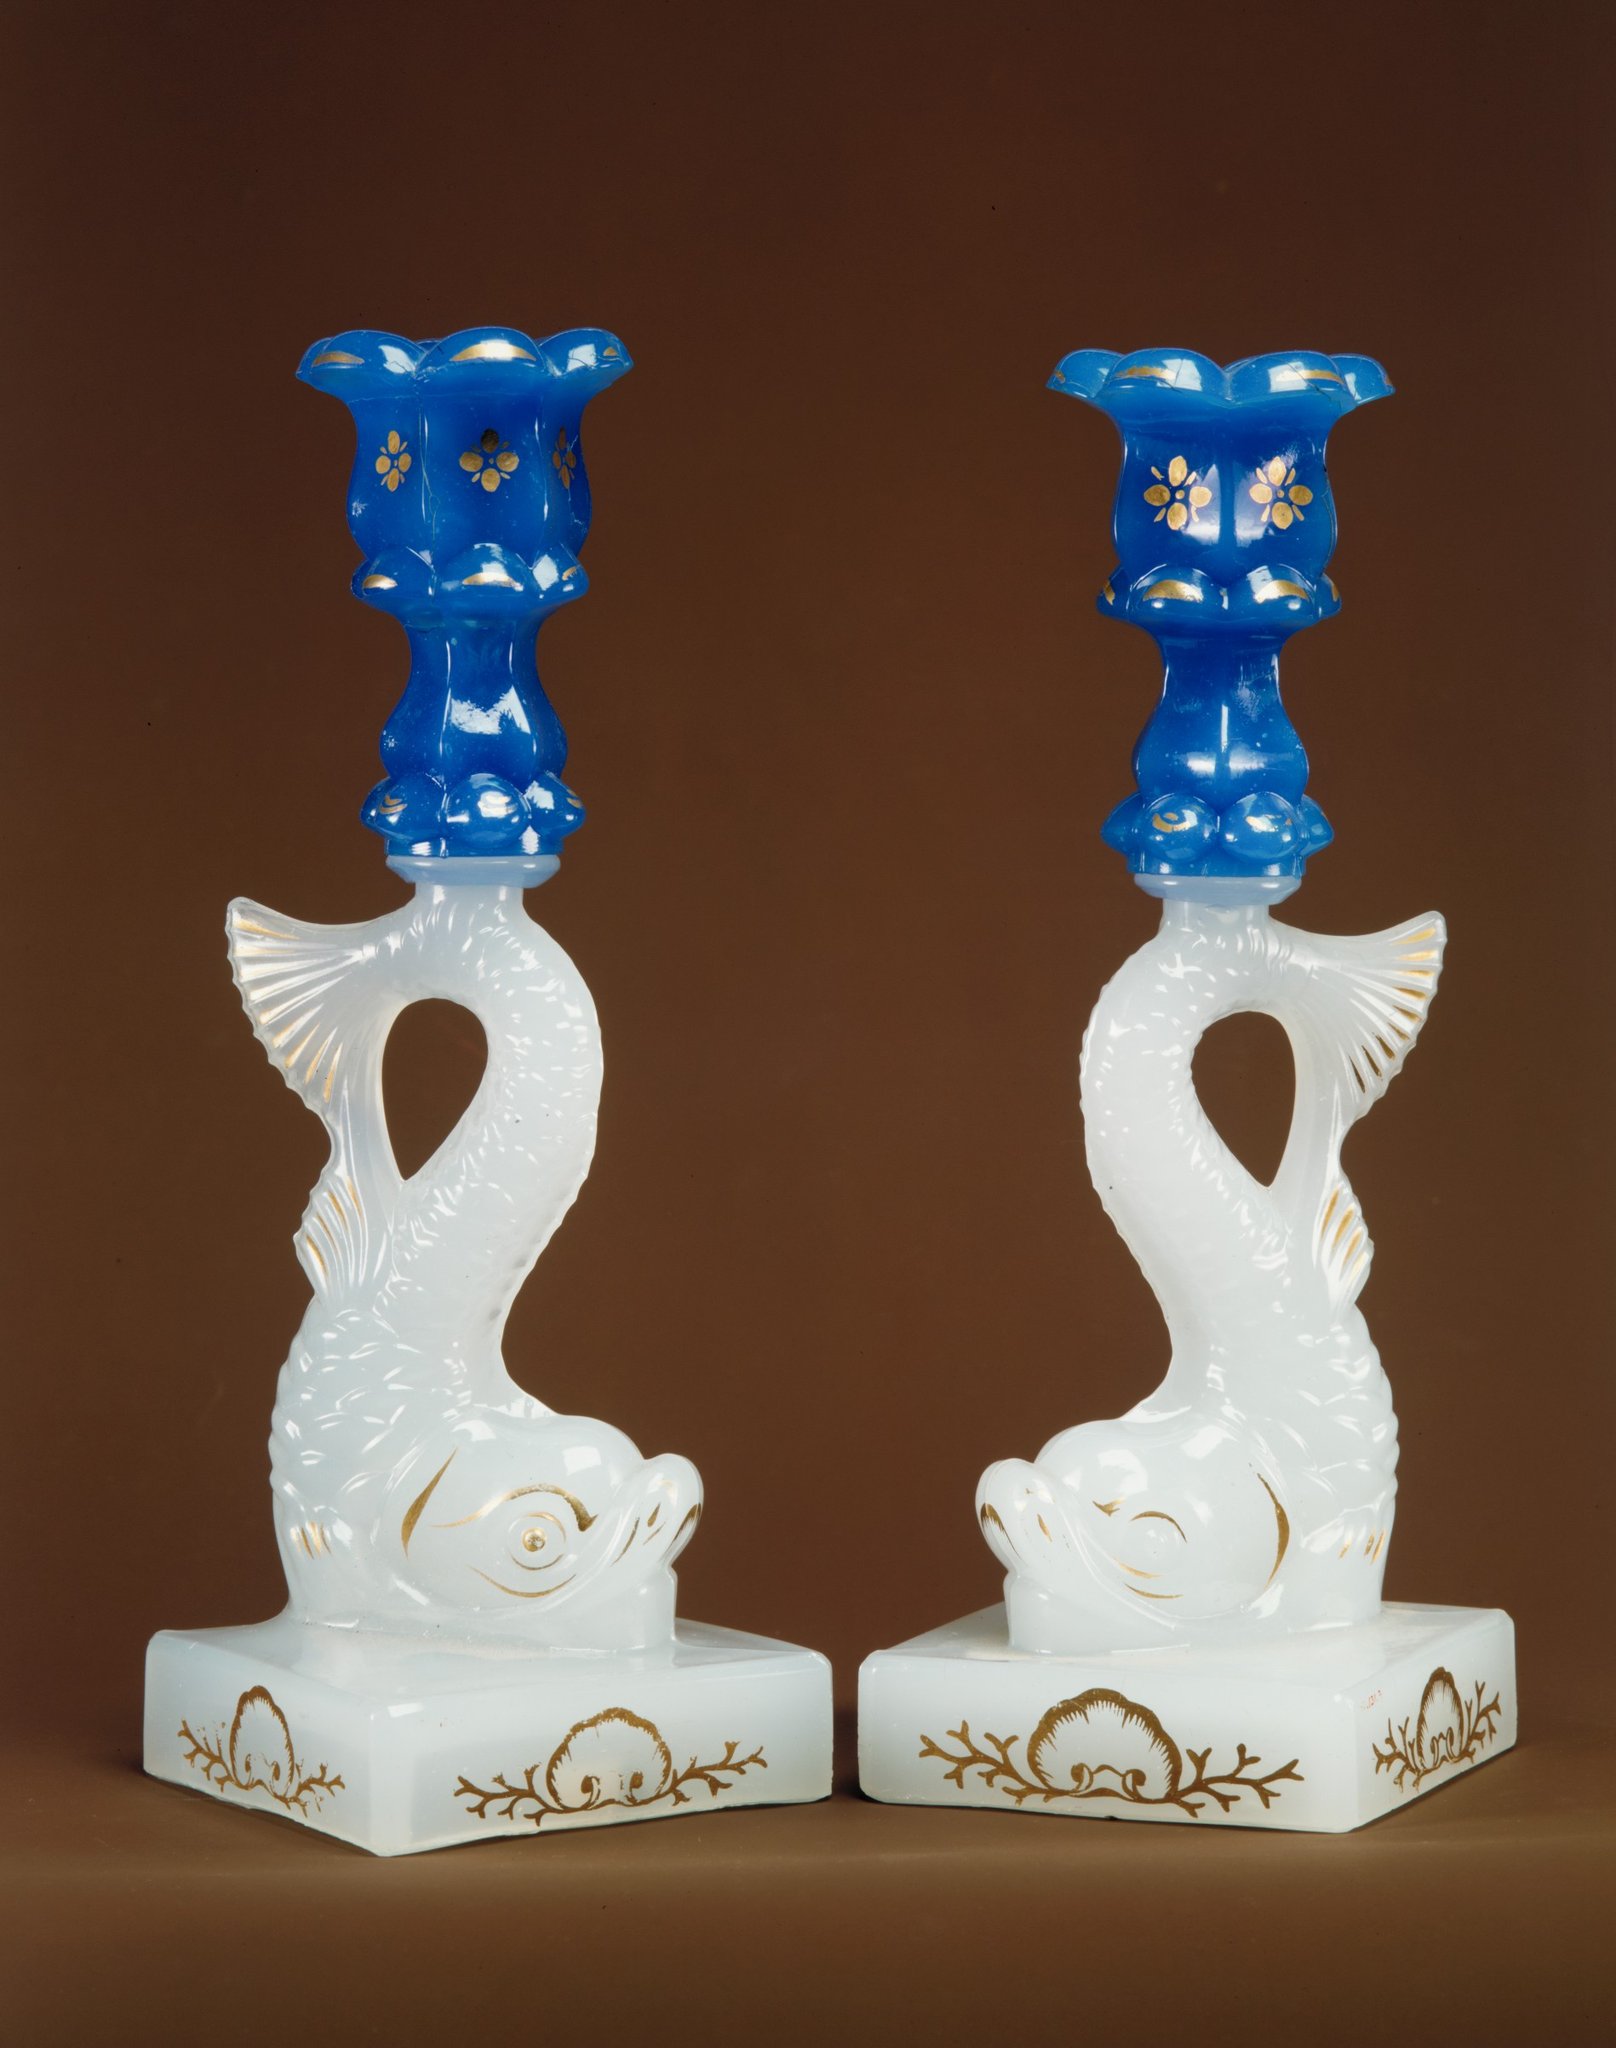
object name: candlestick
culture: american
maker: boston & sandwich glass company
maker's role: maker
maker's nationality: american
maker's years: 1825-1888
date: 1845-1865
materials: glass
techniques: pressed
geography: united states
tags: dolphins